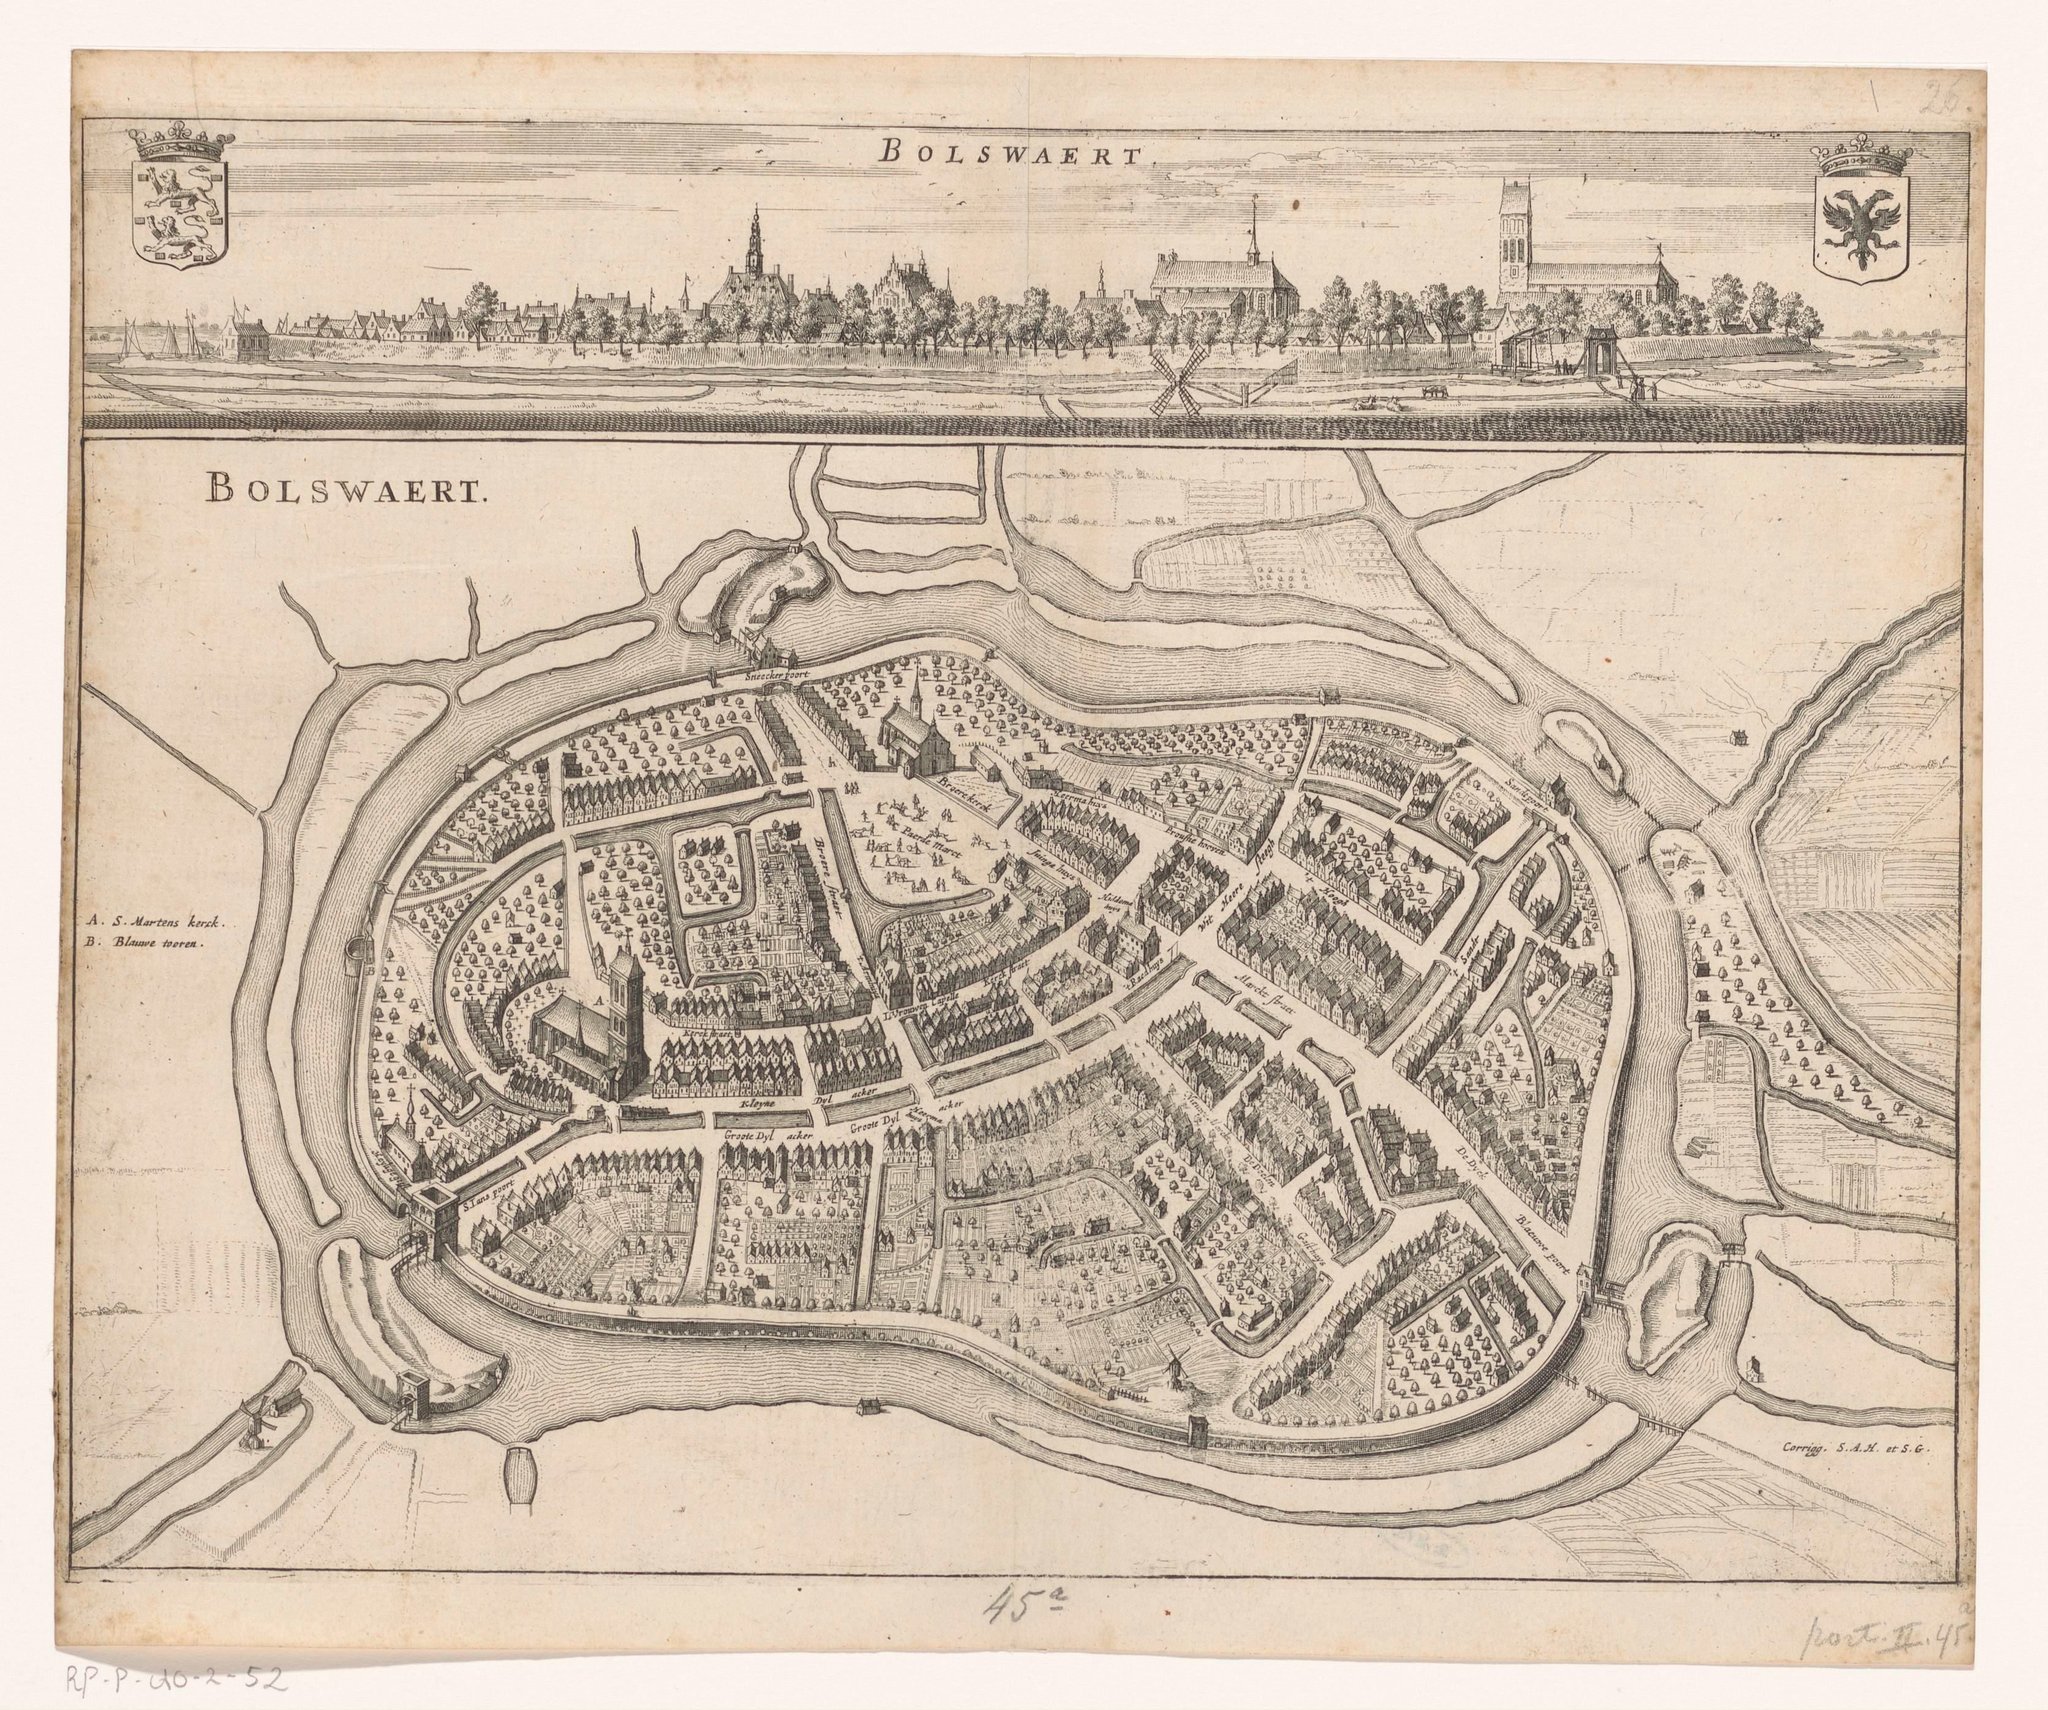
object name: area plan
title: Bolswaert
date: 1664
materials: paper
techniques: engraving, etching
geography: friesland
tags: coat of arms (as symbol of the state, etc.) (+ city; municipal), maps of cities, coat of arms (as symbol of the state, etc.) (+ province; provincial), prospect of city, town panorama, silhouette of city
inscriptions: collector's mark: Lugt 2228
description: Bovenaan een stadsgezicht van Bolsward met daarop links het wapen van Friesland en rechts dat van Bolsward. Daaronder een plattegrond van de stad in vogelvluchtperspectief. Links legenda.